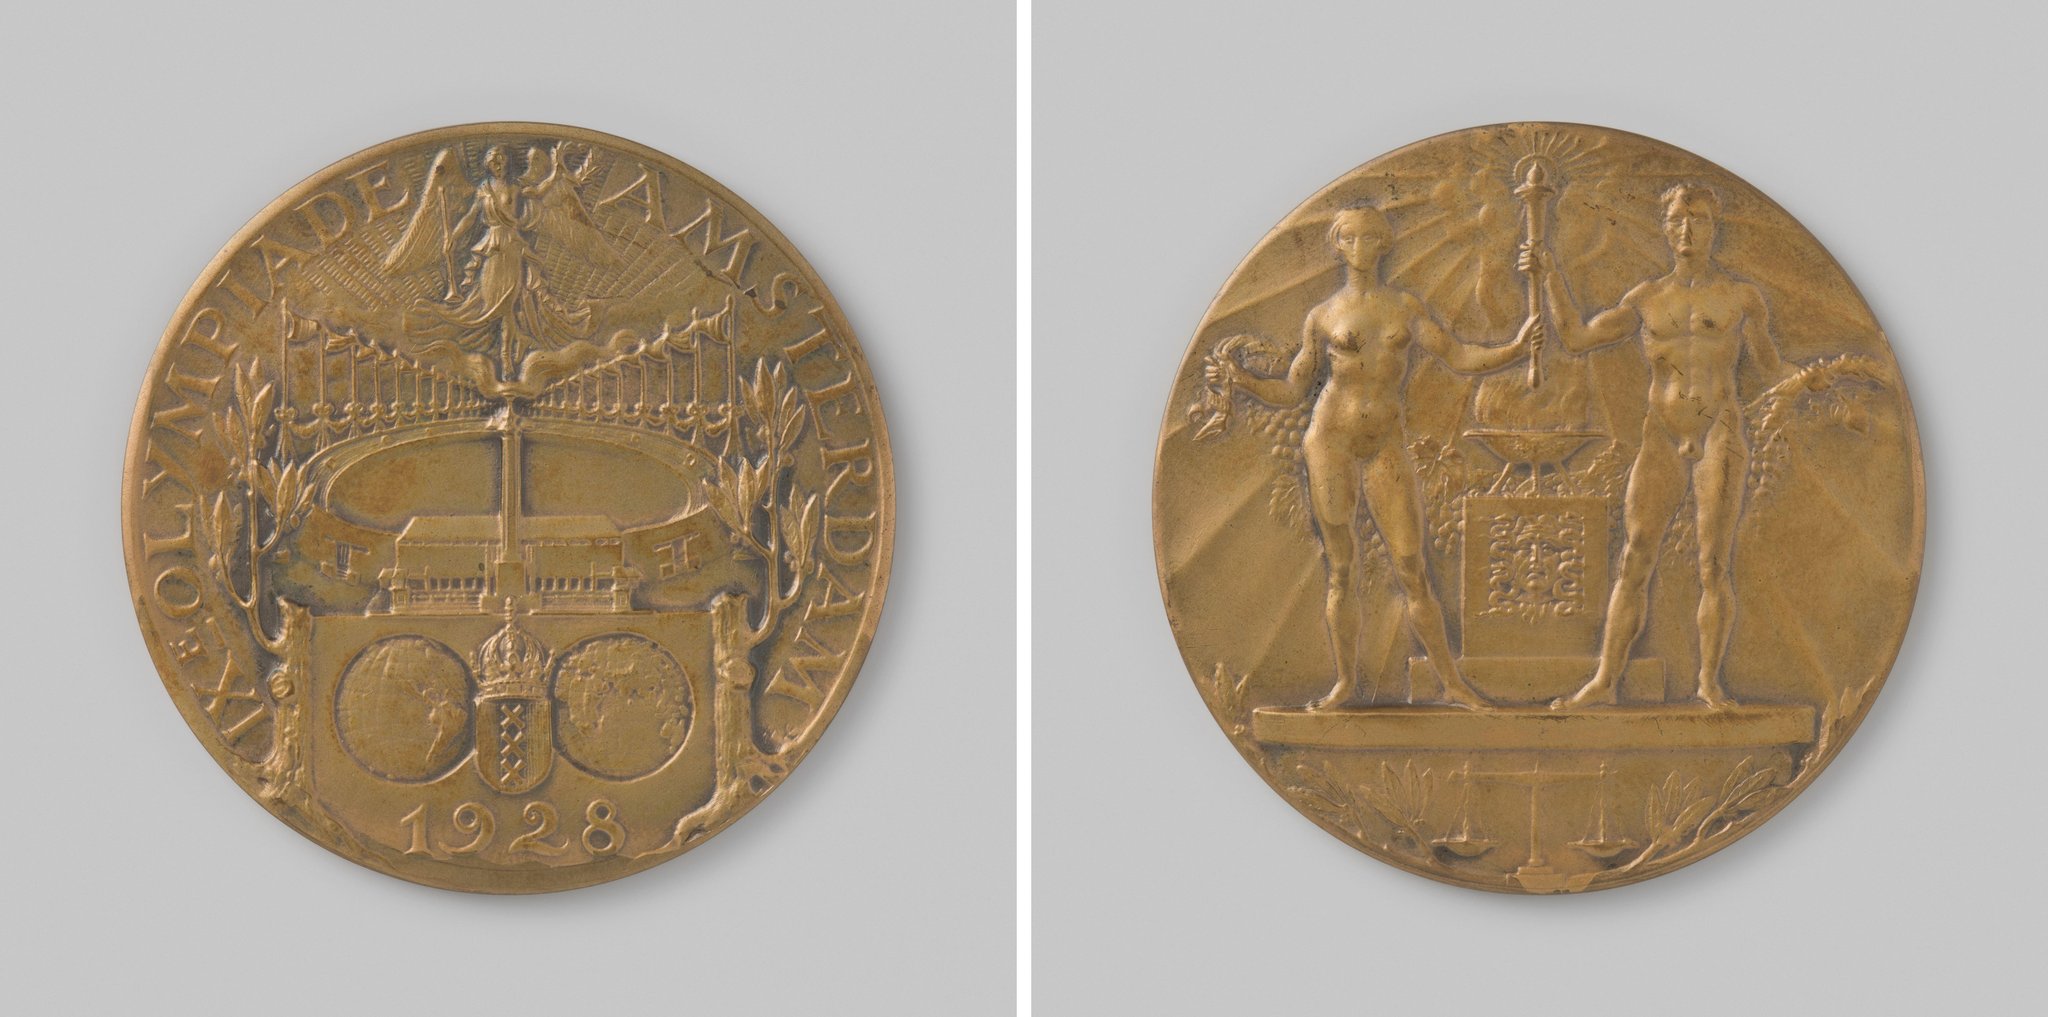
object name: medal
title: Negende Olympiade (Olympische Spelen) te Amsterdam, 1928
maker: johannes cornelis wienecke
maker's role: medailleur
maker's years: 1872-1945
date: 1928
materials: bronze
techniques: striking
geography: netherlands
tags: amsterdam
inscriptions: circumscription: ‘IXe OLYMPIADE AMSTERDAM’, date: ‘1928’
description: Bronzen penning. Voorzijde:: stadion met op tribunes rij vlaggen, hierboven gevleugelde vrouw met lauwerkrans in linkerhand en trompet in rechterhand, voor waaierachtige versiering, onder twee zijden wereldbol waartussen wapen Amsterdam, met omschrift en onderschrift. Keerzijde: naakte man (rechts) en vrouw op podium, die samen lichtgevende toorts vasthouden en achter hun langs ook een druivenrank, staande voor altaar waarop brandende schaal; onder podium weegschaal en gebladerde takken.